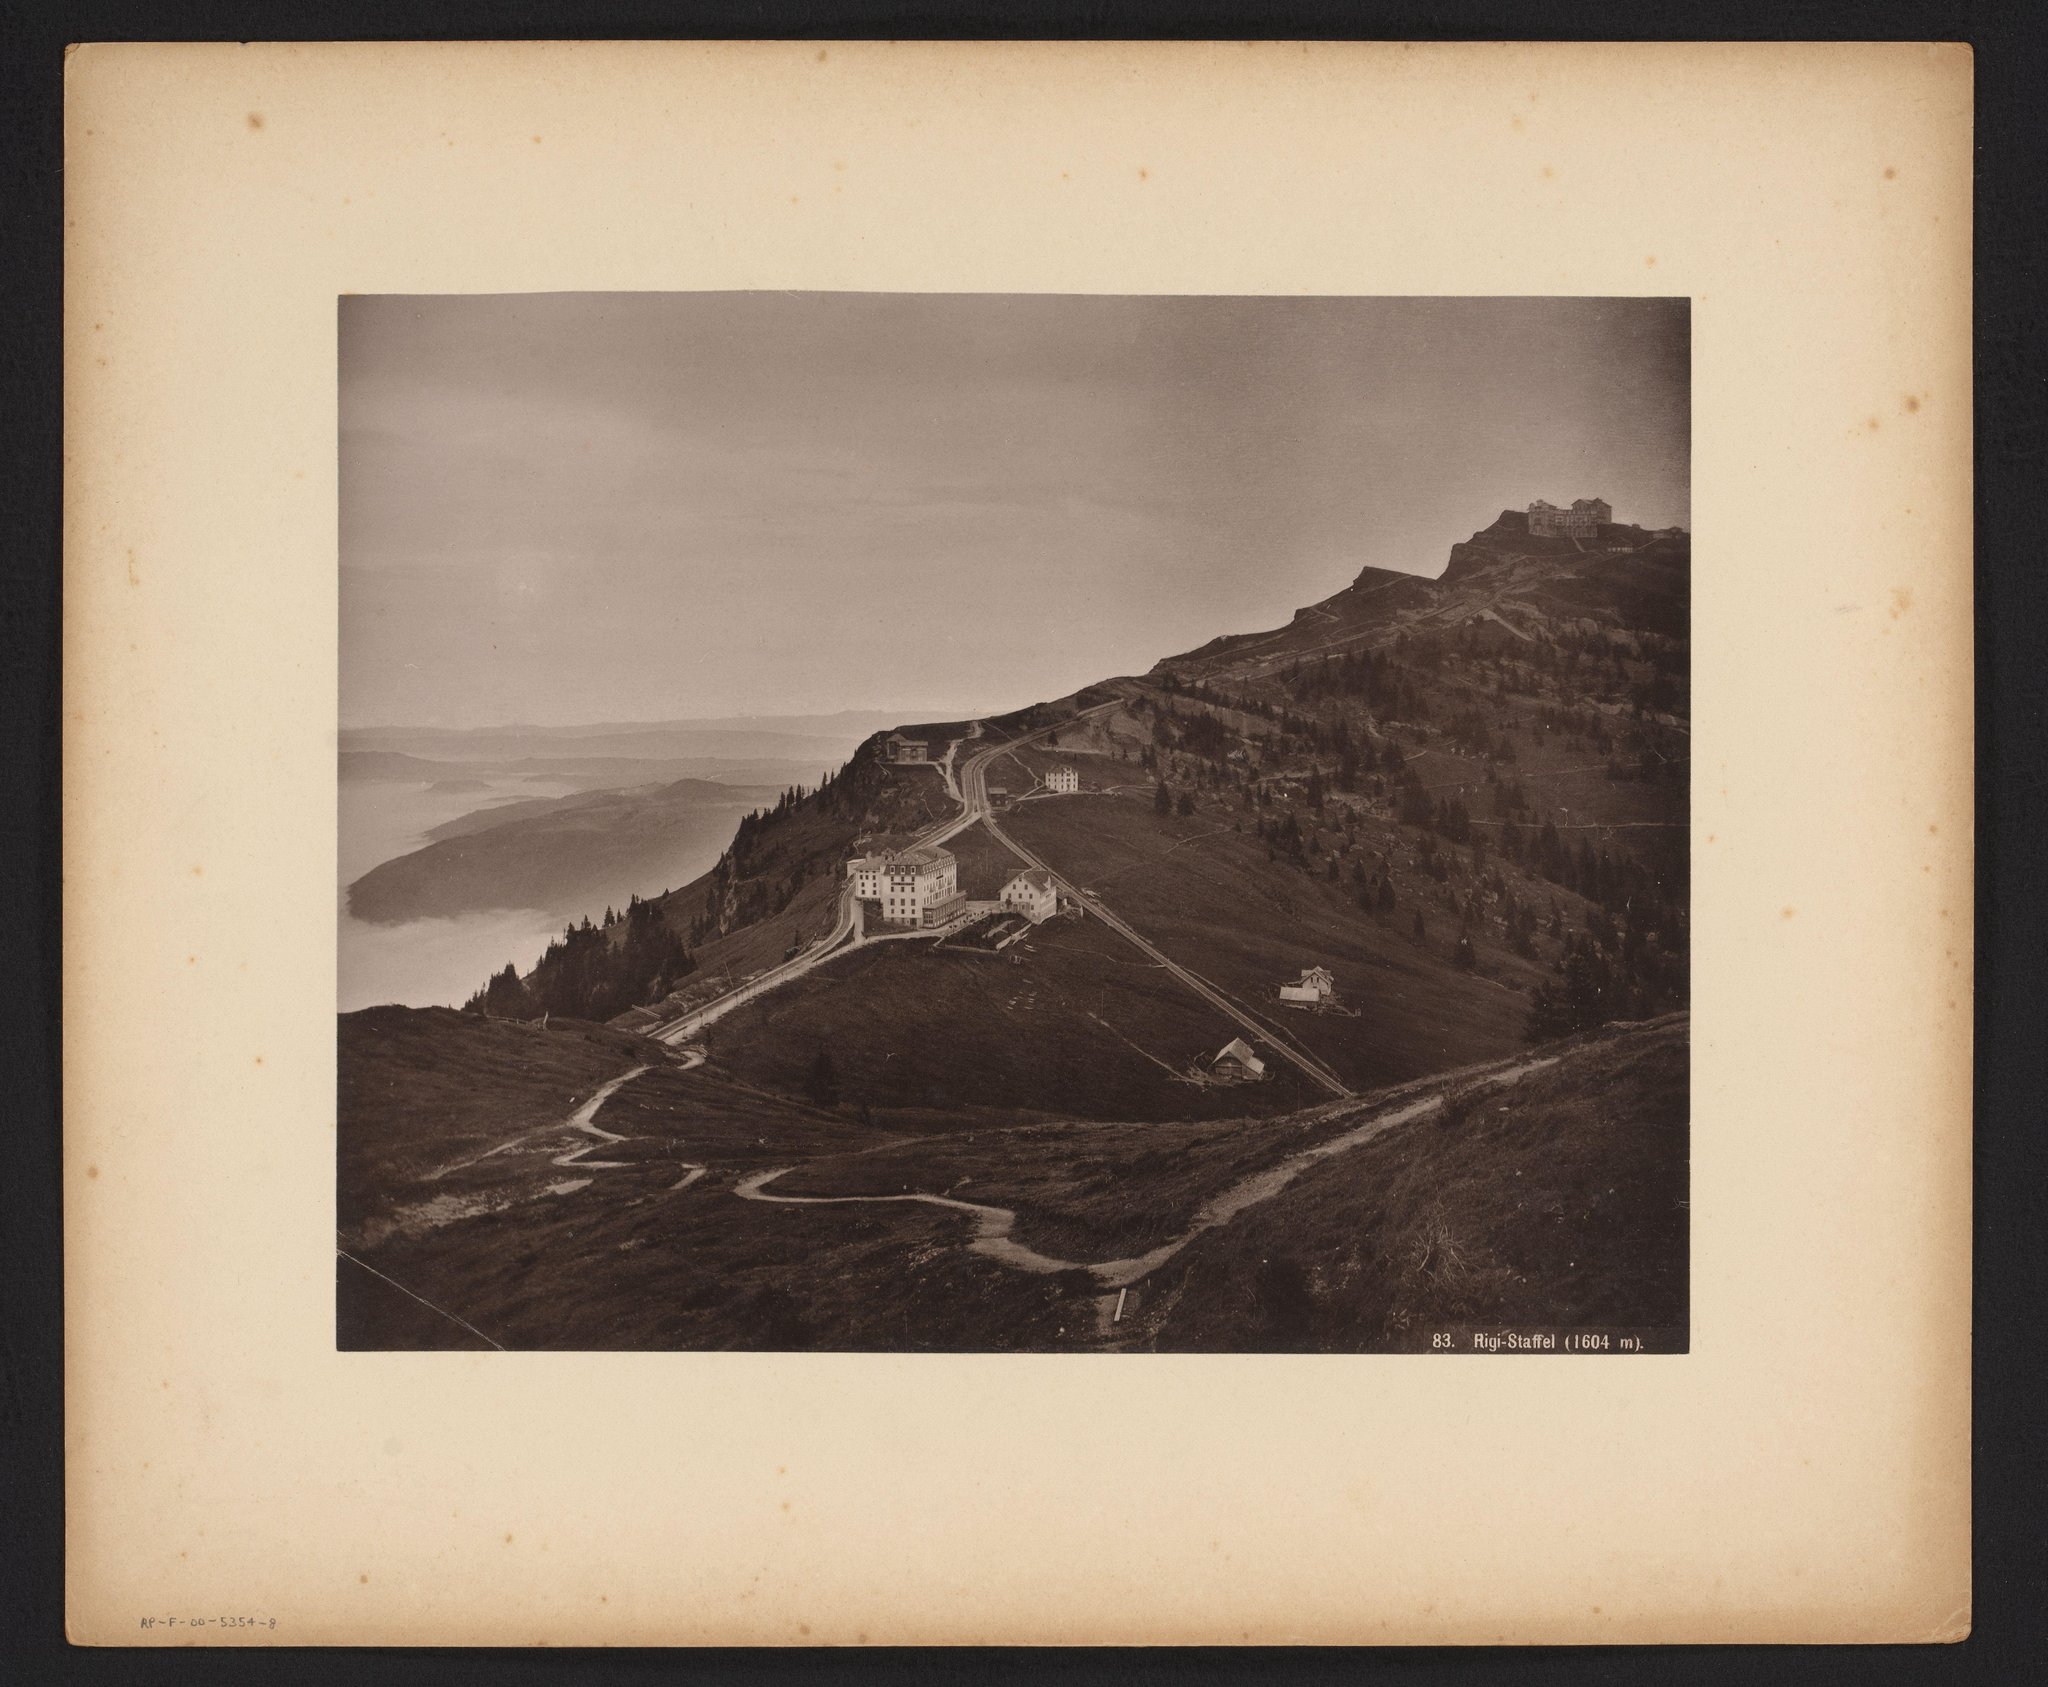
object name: photomechanical print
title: Rigi-Staffel (1604 m).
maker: Anonymous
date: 1890-1910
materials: cardboard, paper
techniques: photograph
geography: rigi kulm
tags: railway, train, mountains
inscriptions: inscription: ‘83. Rigi-Staffel (1604 m).’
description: Deze fotomechanische afdruk maakt deel uit van een omslag.